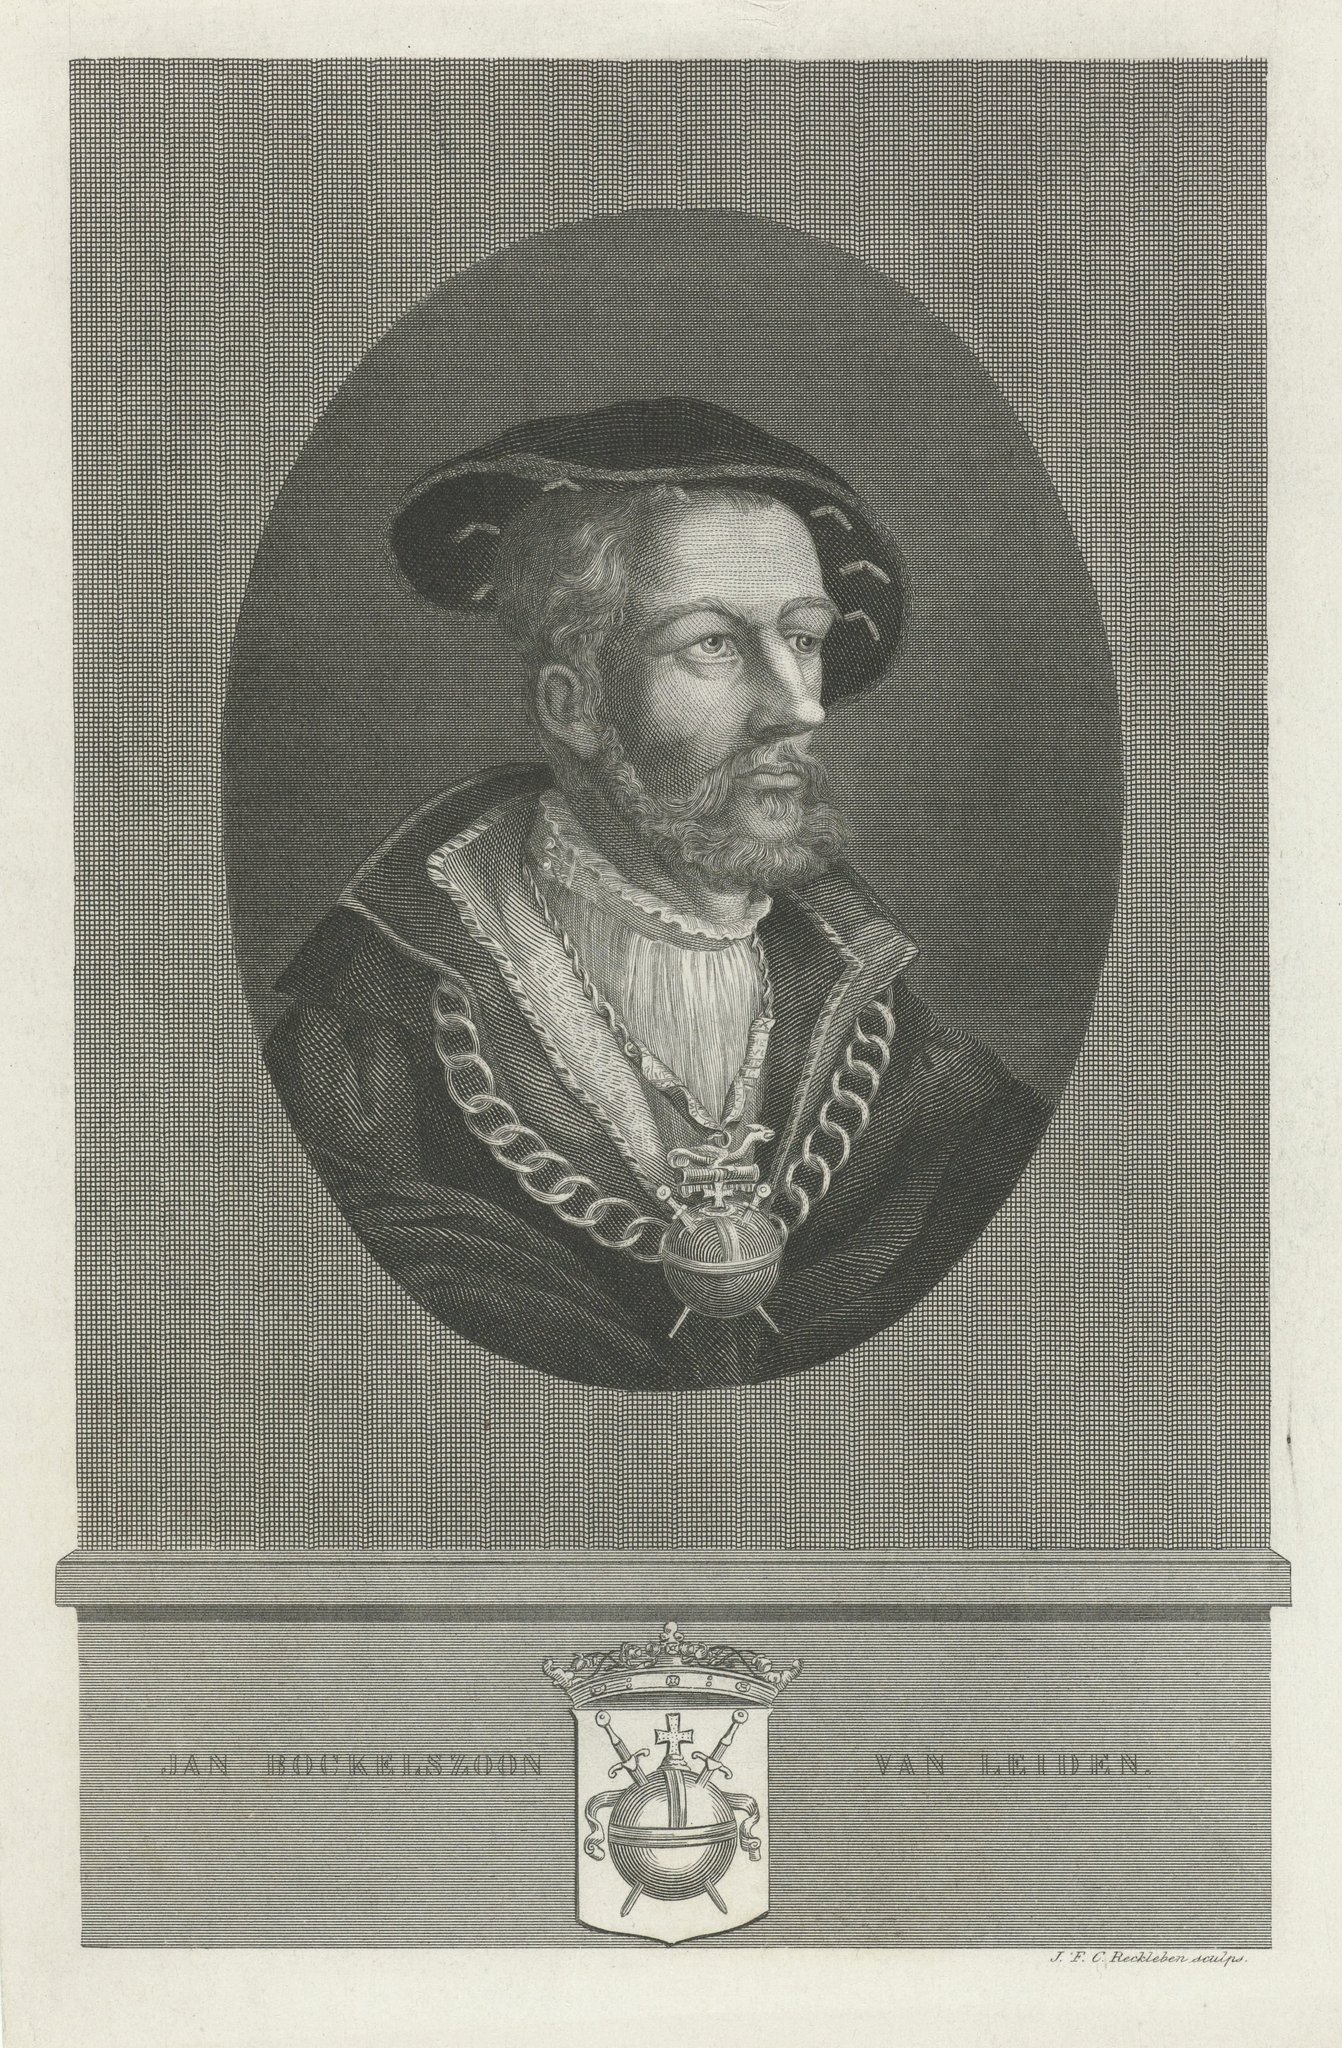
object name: print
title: Portret van Jan van Leiden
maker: jan frederik christiaan reckleben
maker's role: print maker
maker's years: 1819-1879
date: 1847-1849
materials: paper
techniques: engraving, etching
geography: amsterdam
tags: leiden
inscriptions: collector's mark: Lugt 2228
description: Portret van Jan Beukelszoon van Leiden, leider van de radicale wederdopers en door zichzelf benoemd als koning van de wederdopers te Münster. In de marge zijn naam en familiewapen.